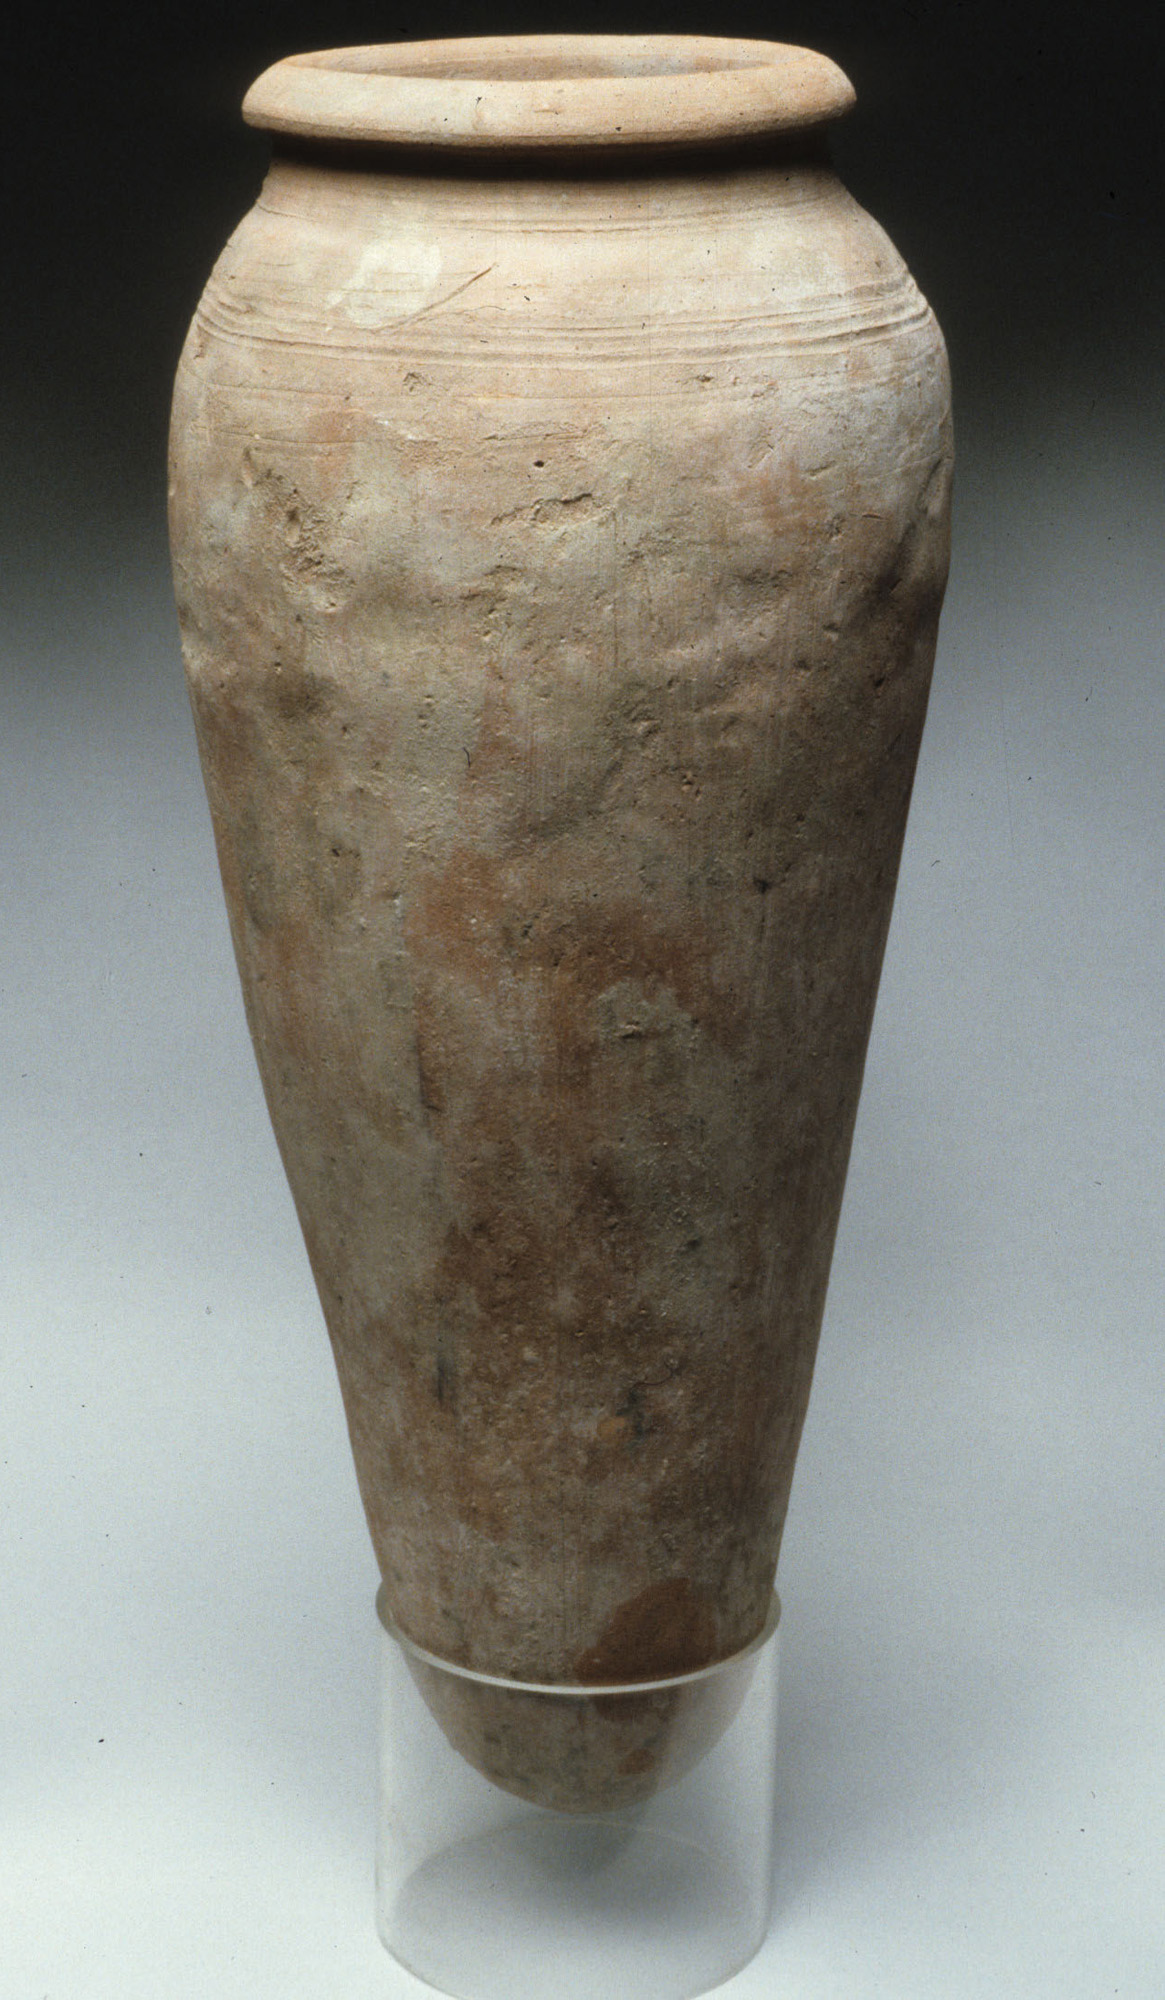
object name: jar, late ware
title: Large late ware storage jar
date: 3300-3100 BCE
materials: pottery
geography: egypt